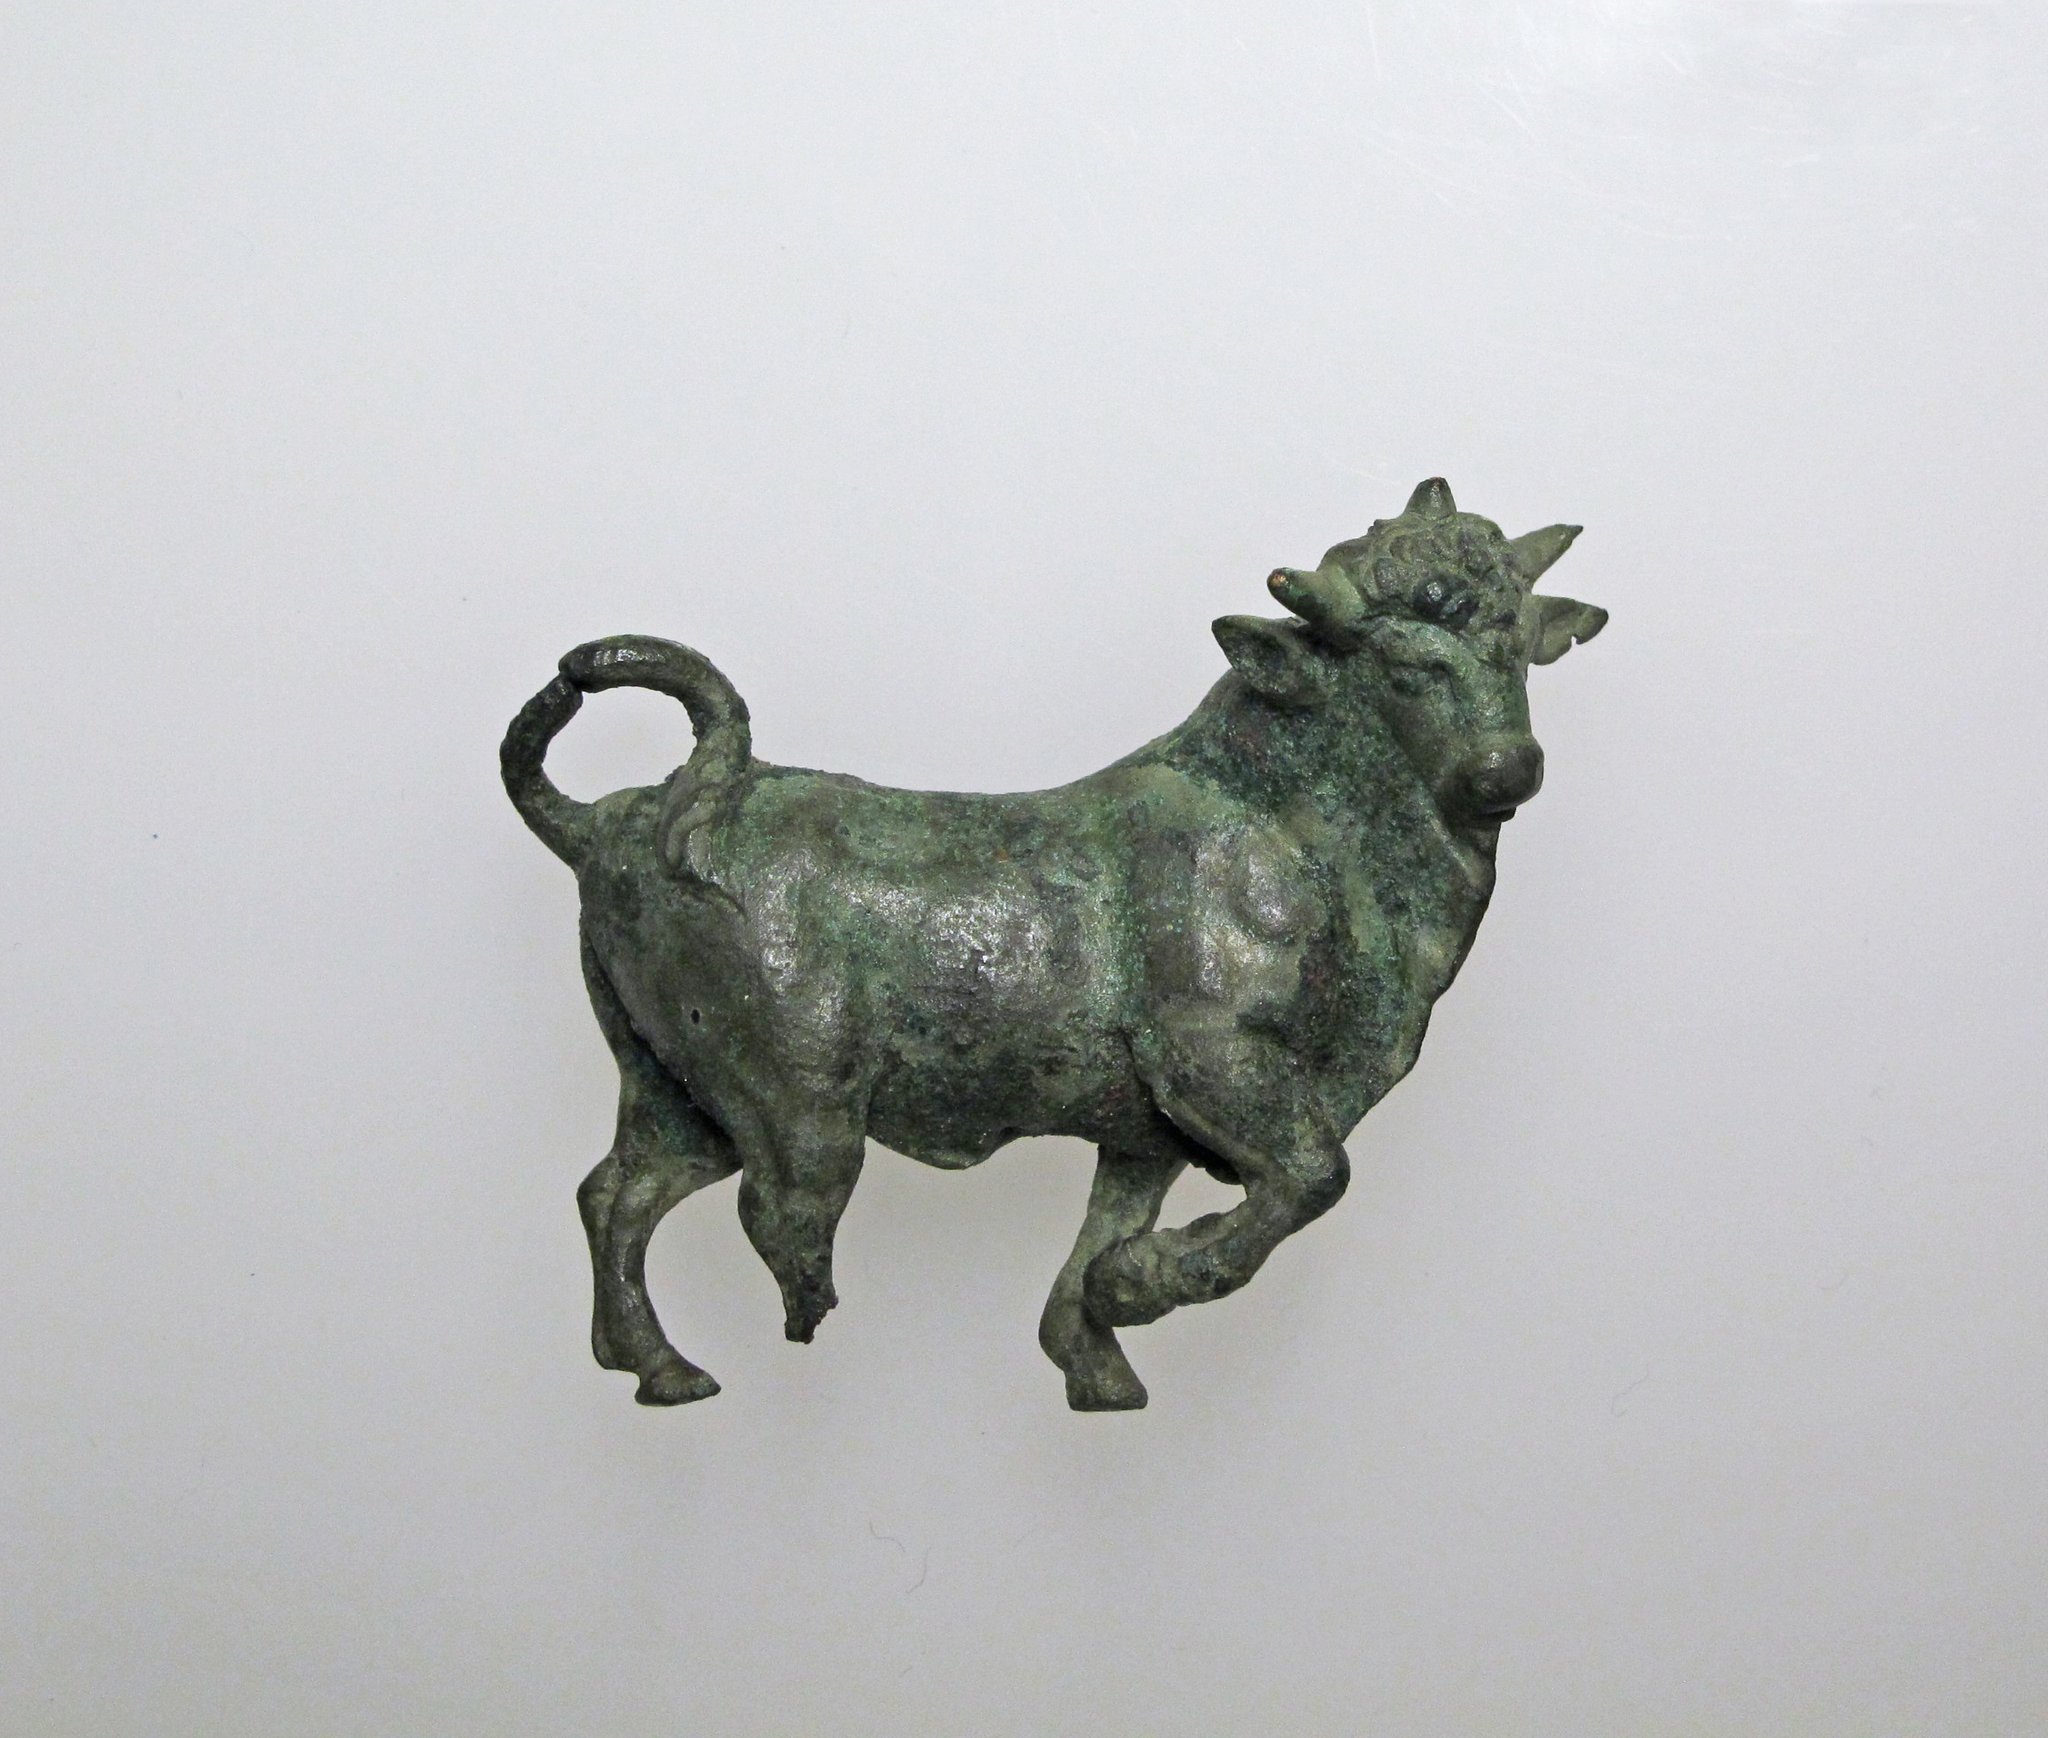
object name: statuette of a bull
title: Bronze statuette of a bull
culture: roman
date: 1-200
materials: bronze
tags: bulls